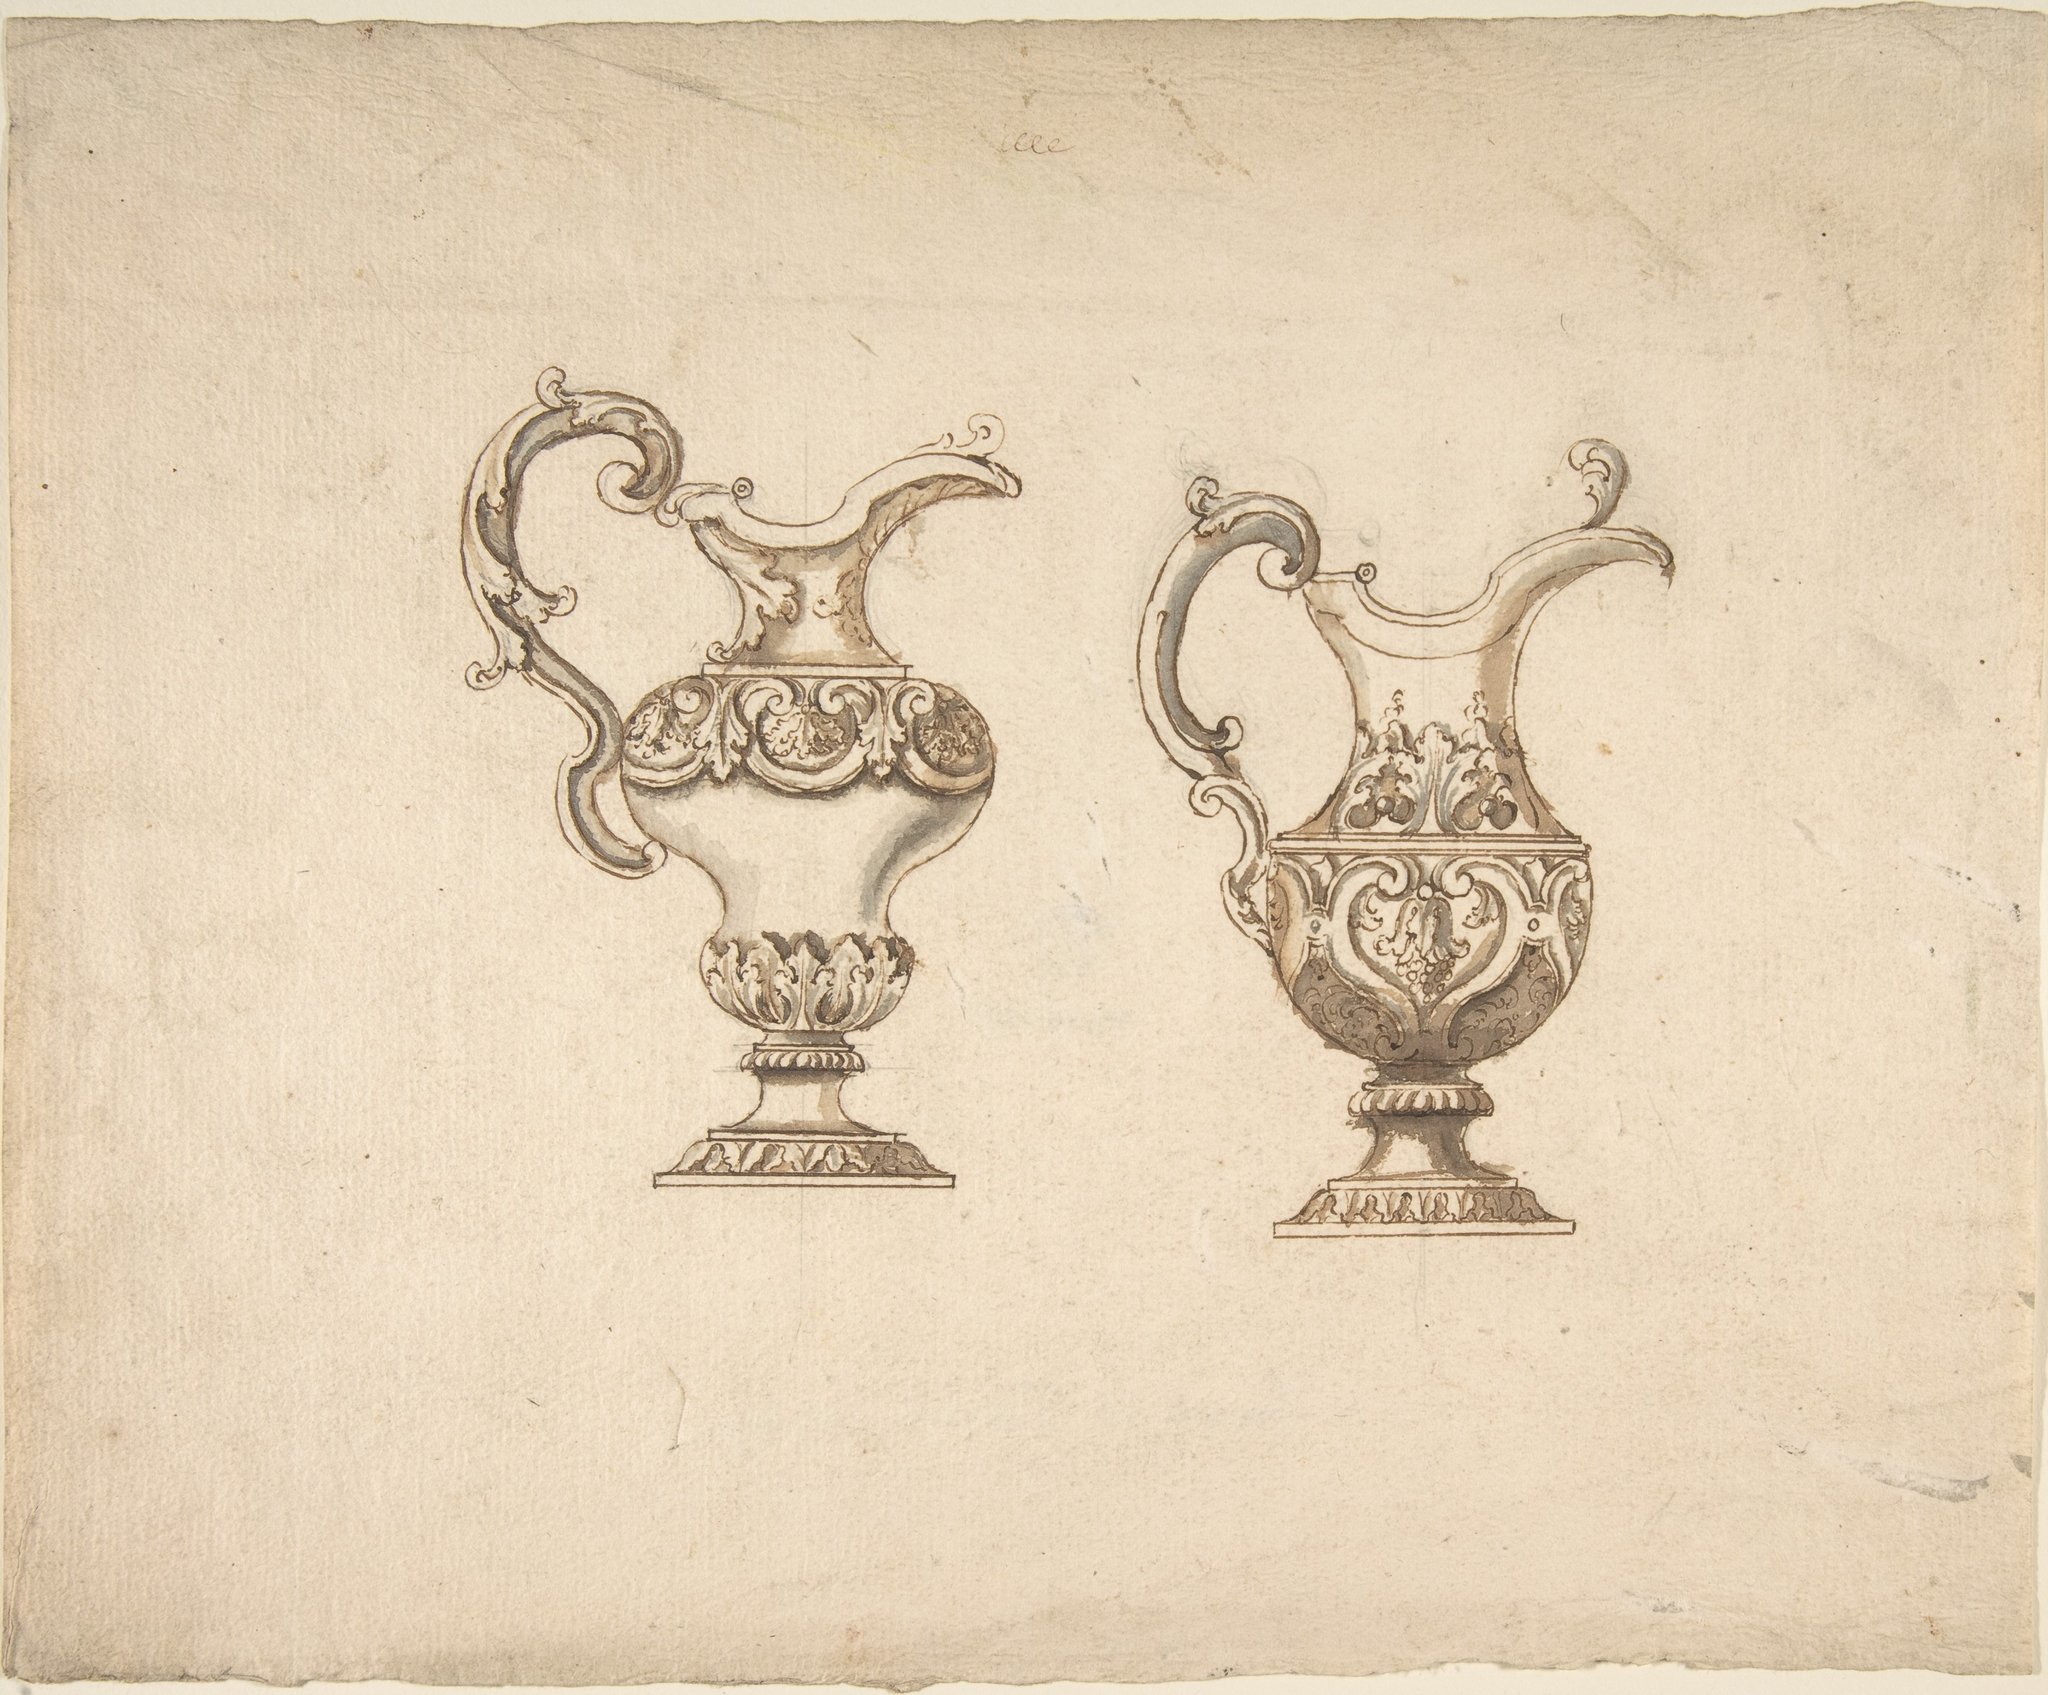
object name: drawing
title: Two Vases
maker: anonymous, italian, 18th century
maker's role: artist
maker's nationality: italian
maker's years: 1700-1800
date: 1701-1800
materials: ink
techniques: wash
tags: vases